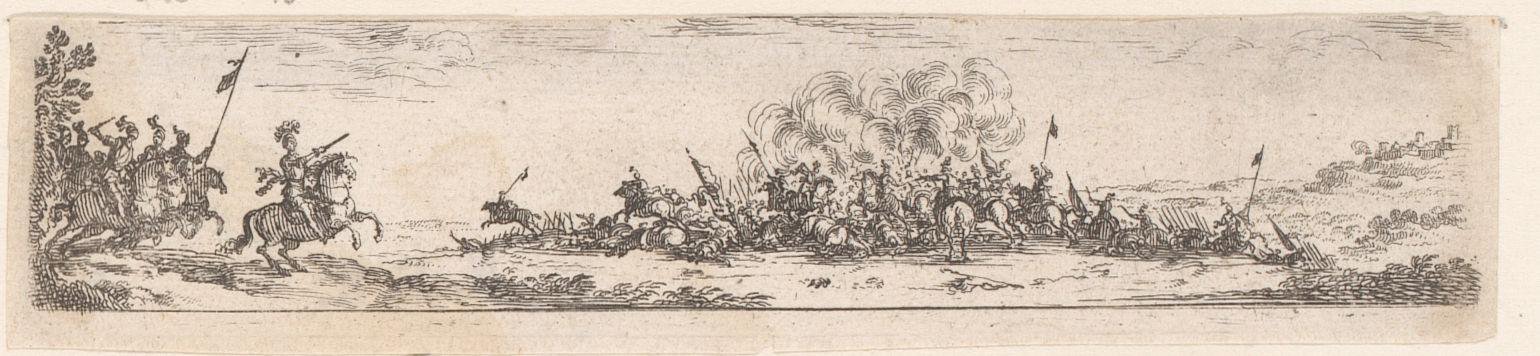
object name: print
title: Vignetten met buitentaferelen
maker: nicolas cochin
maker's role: print maker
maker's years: 1610-1686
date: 1620-1686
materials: paper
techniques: etching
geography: france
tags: landscapes, battle